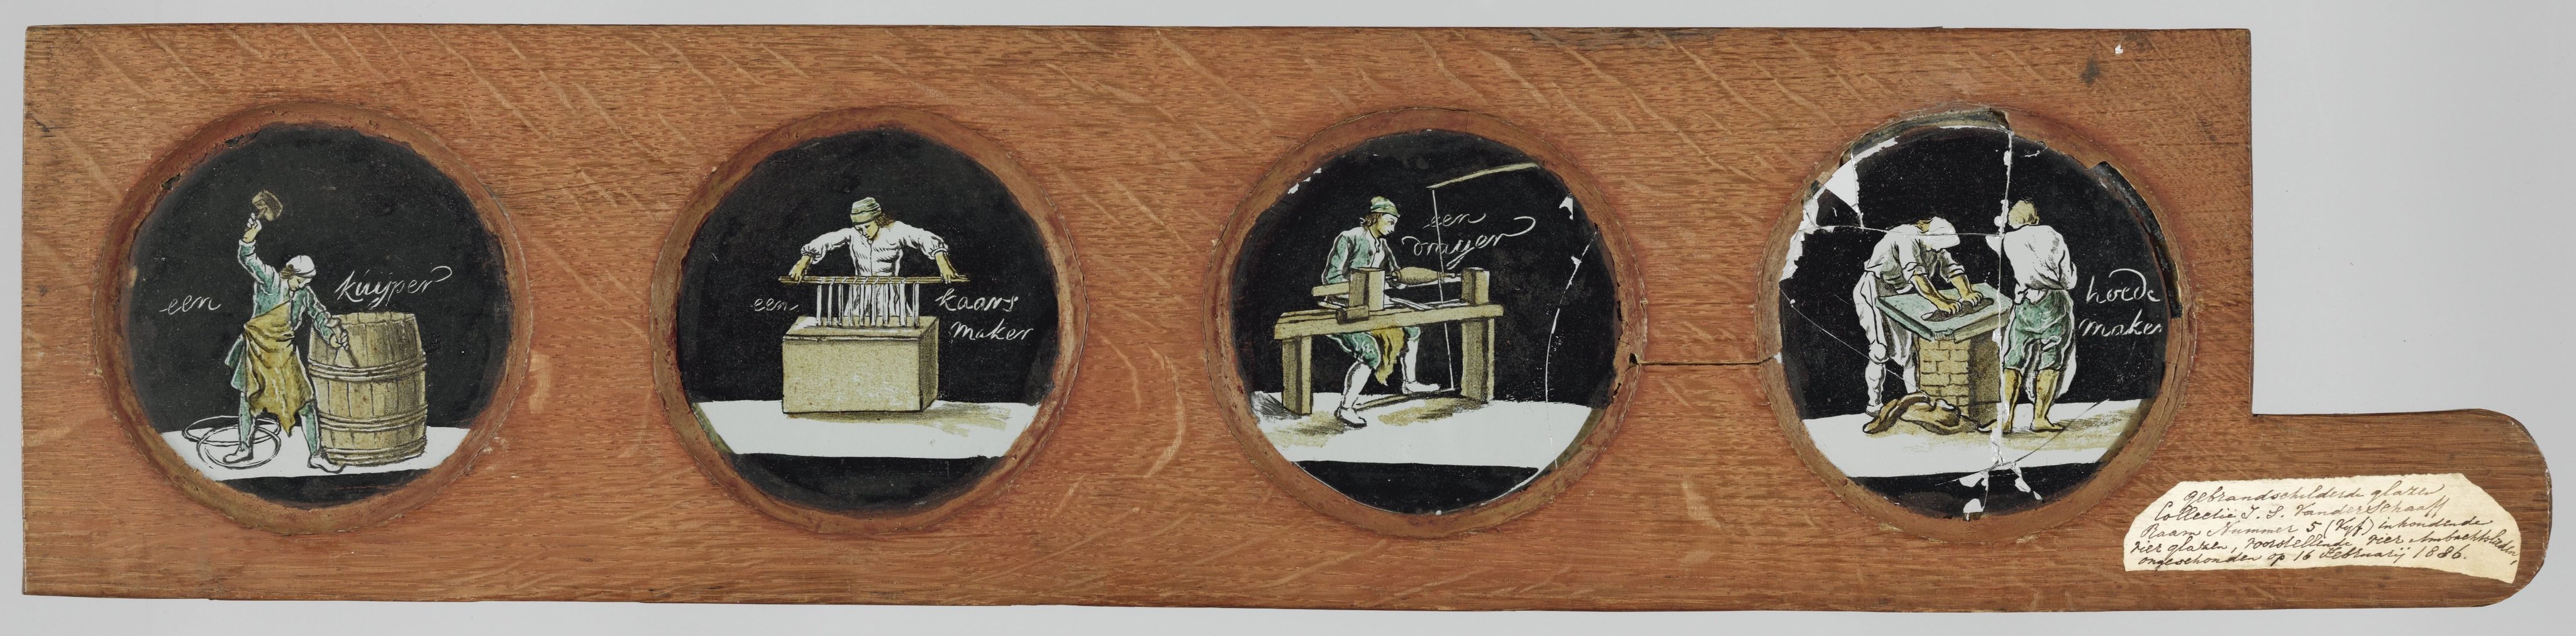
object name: lantern slide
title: Vier beroepen naar Het Menselyk Bedryf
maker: Anonymous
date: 1700-1790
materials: glass, wood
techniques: painted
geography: netherlands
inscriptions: label: ‘'Gebrandschilderde glazen. Collectie I.S. van der Schaaff, Baarn. Nummer 5 (vijf) inhoudende vier glazen, voorstellende vier ambachten, ongeschonden en heel op 16 februarij 1886.'’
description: Vier glazen in een houten vatting met handvat. Uiterst links, 'een kuijper' brengt met kuipershamer hoepen om een ton aan. Rechts daarvan: 'een kaarsmaker' tilt de lat met kaarsen uit het bad. Rechts daarvan 'een draijer' zittend achter een houtdraaibank. Uiterst rechts: 'hoedemaker', twee mannen werkend aan een tafel, op de grond enkele hoeden.